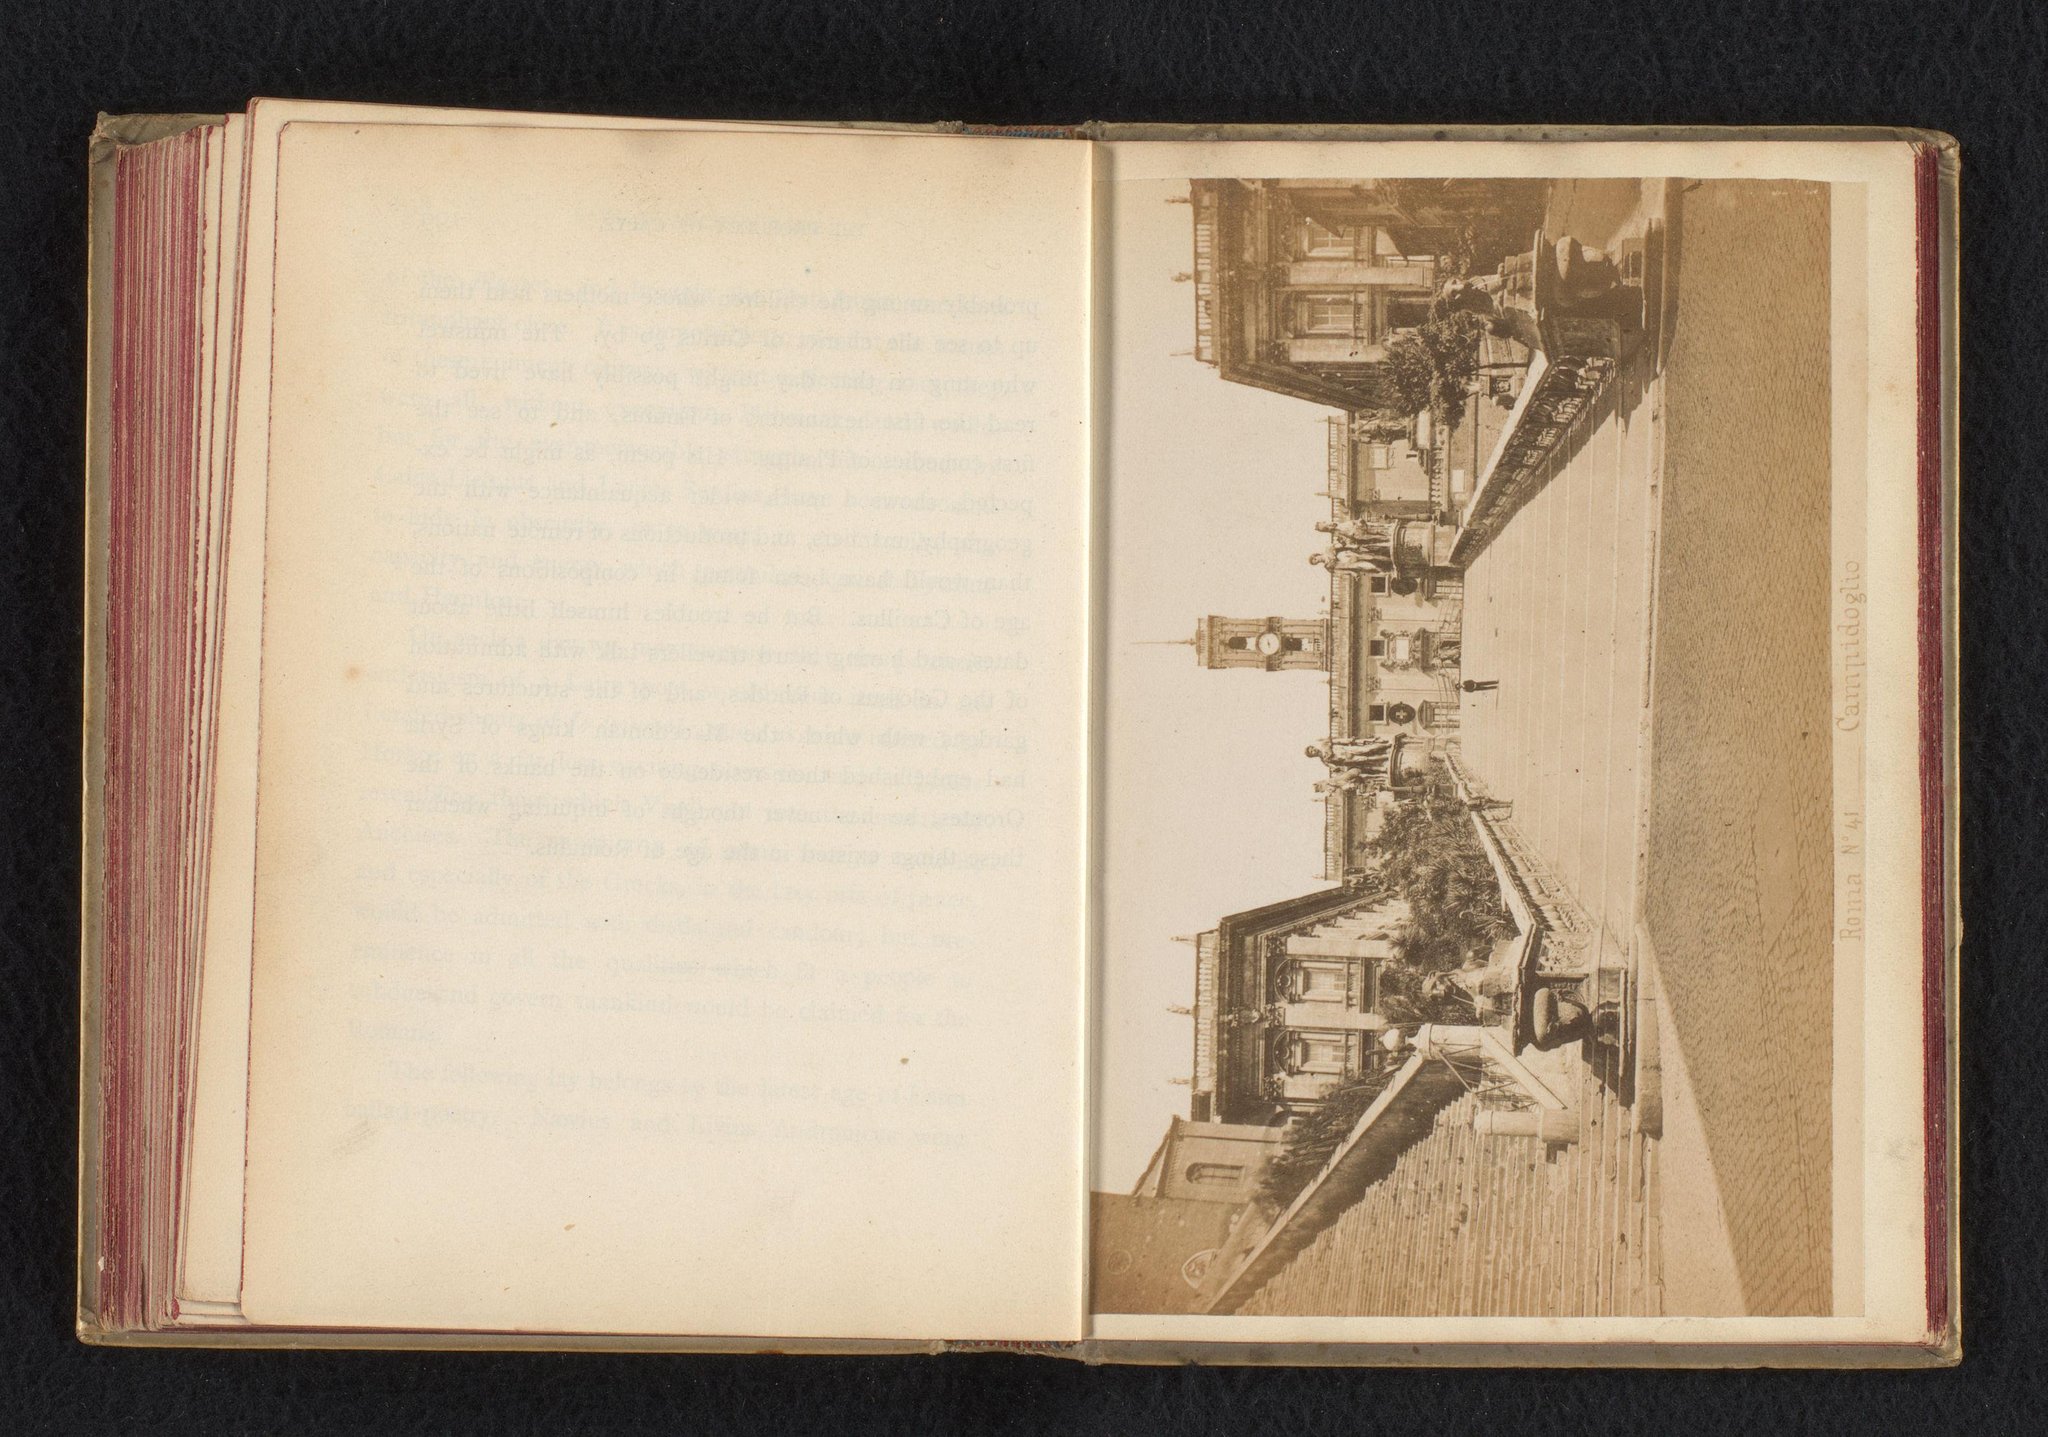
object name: photograph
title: Roma - Campidoglio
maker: Anonymous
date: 1851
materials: paper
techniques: albumen print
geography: rome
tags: sloping street; street with steps or stairs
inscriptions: number: ‘No 41’